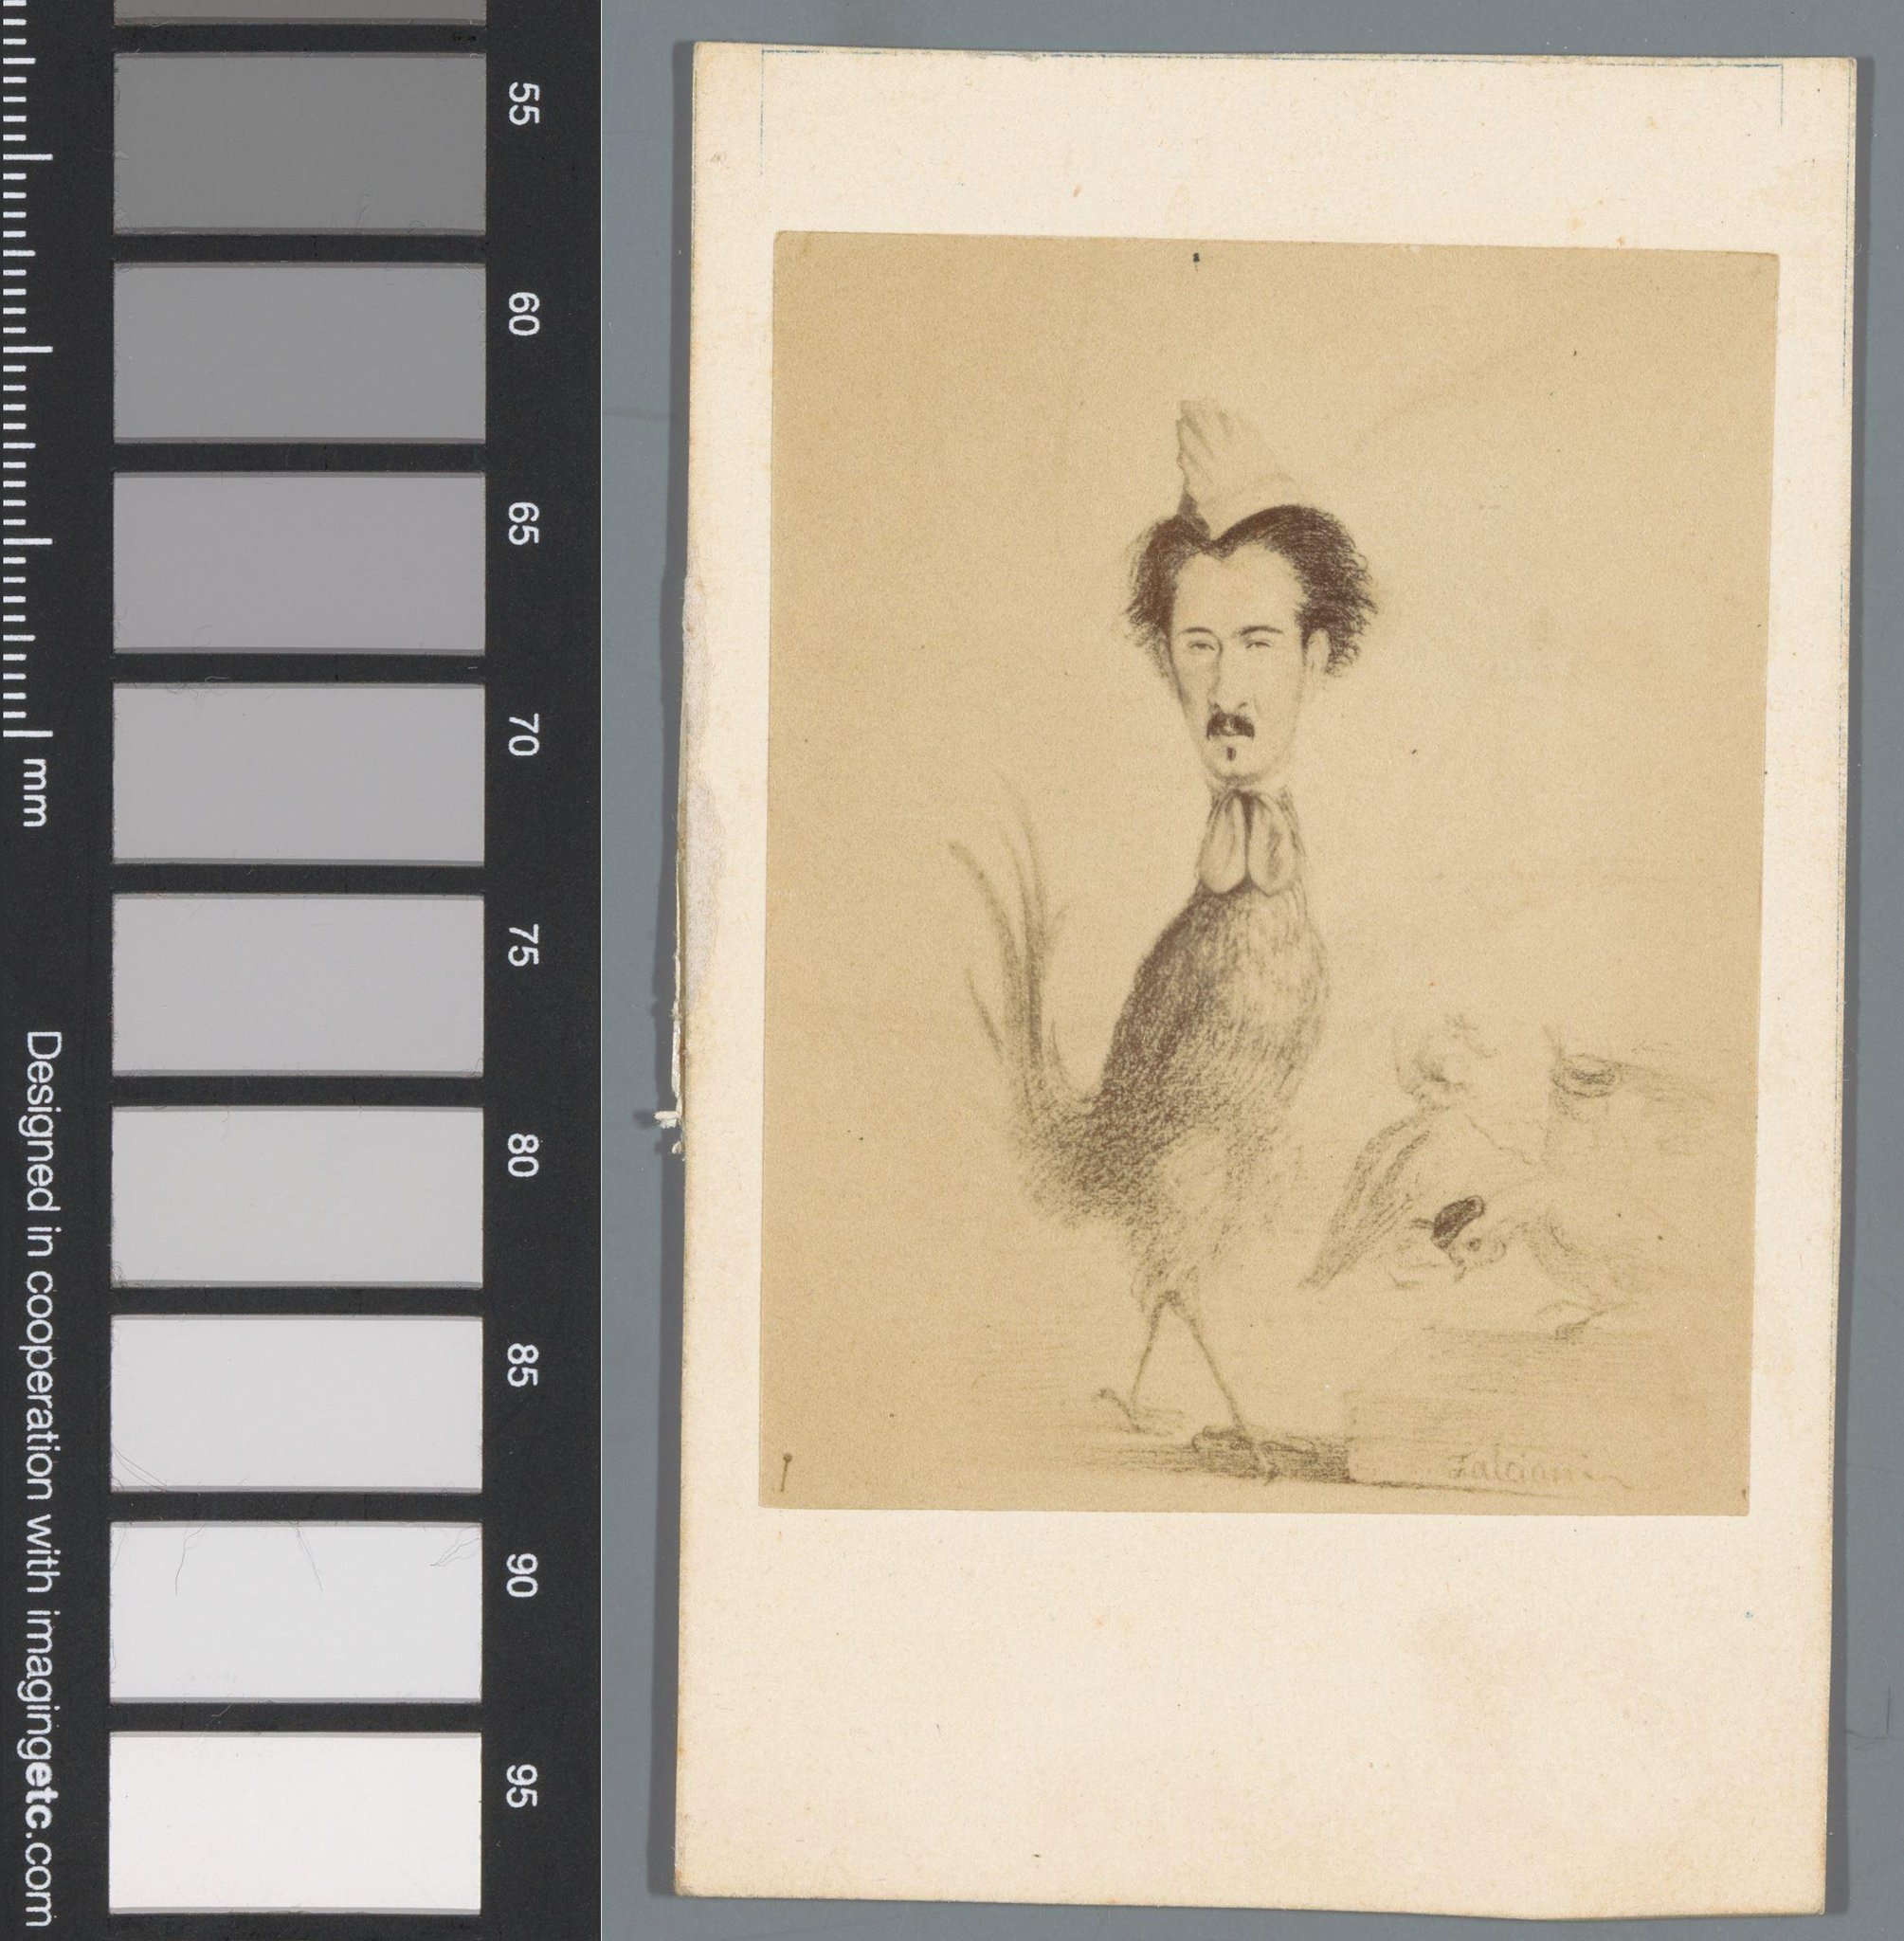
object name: reproduction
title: Fotoreproductie van een spotprent met een karikatuur van een man uitgebeeld als haan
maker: bl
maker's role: fotograaf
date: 1855-1885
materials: cardboard, paper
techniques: albumen print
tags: caricatures (human types)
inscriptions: monogram: ‘BL’